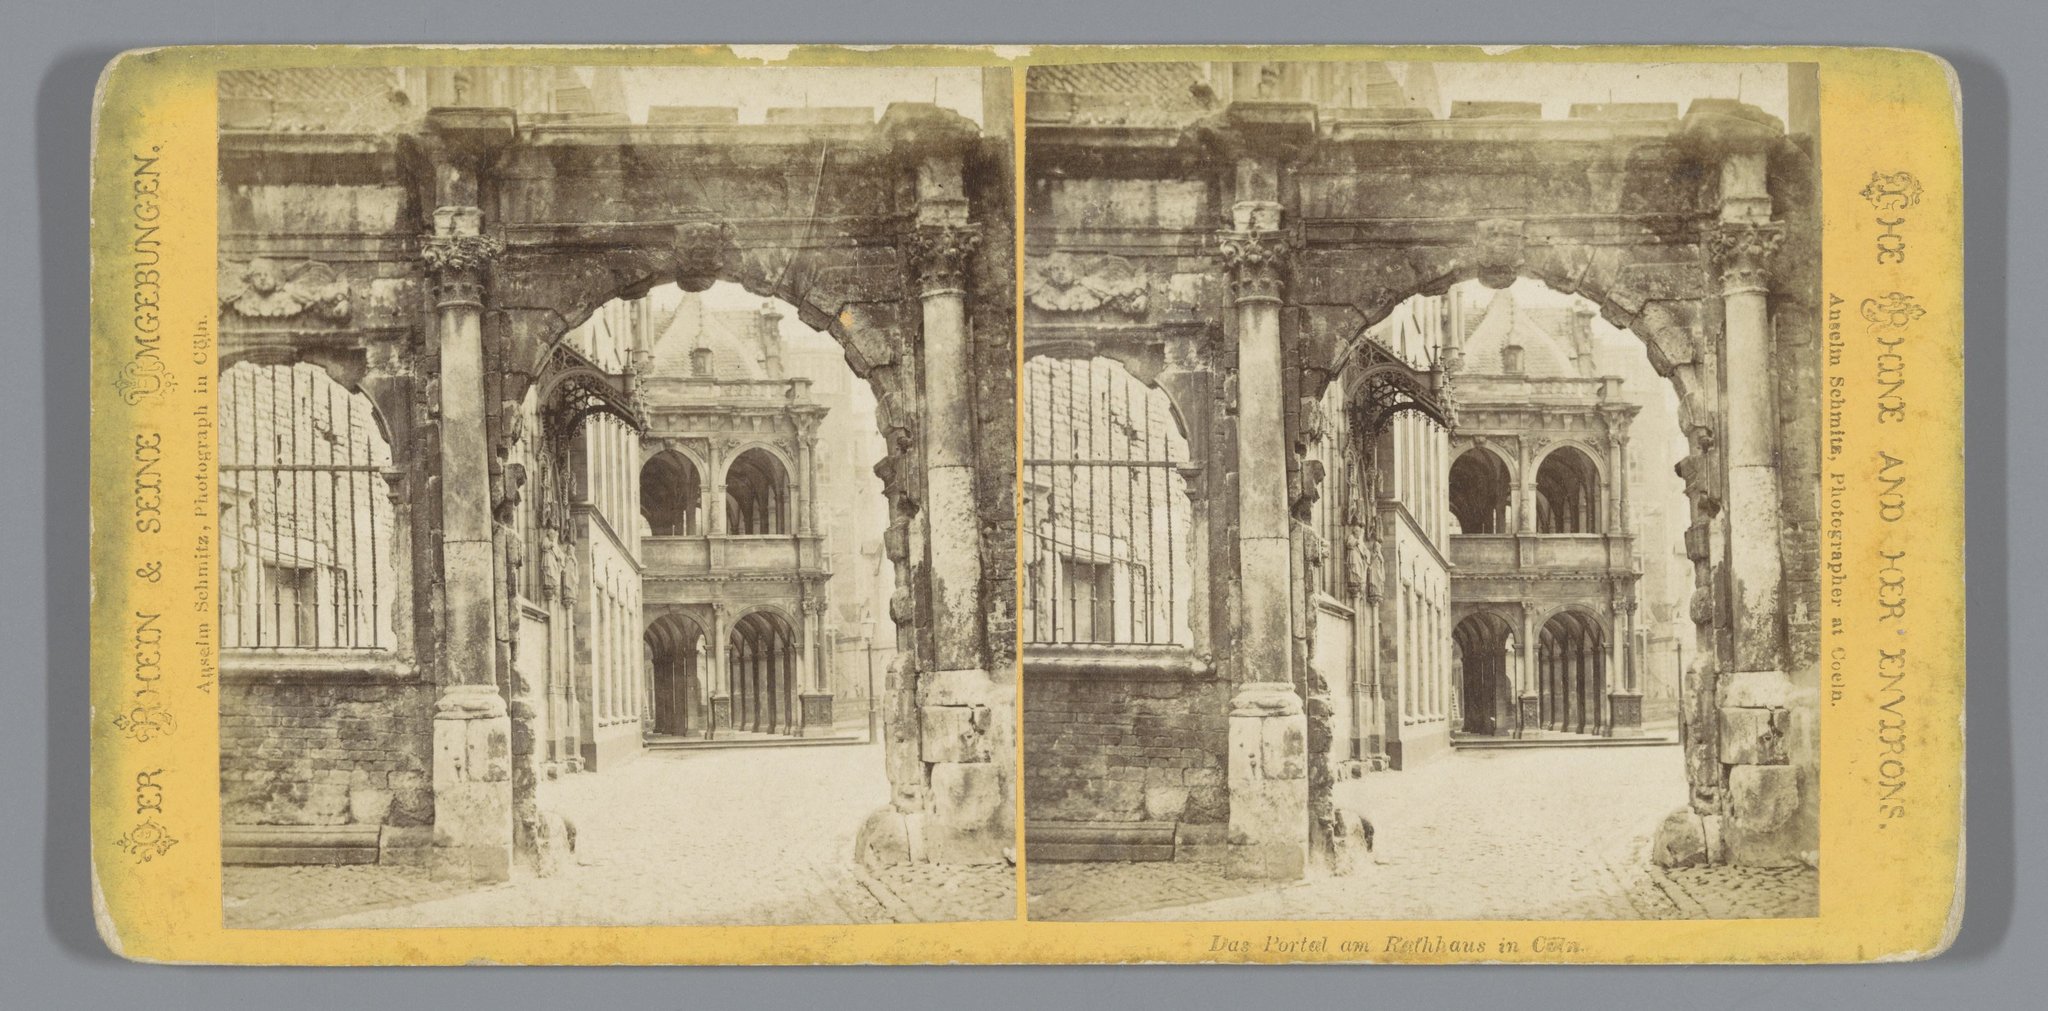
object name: stereograph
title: Das Portal am Rathhaus in Coln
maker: anselm schmitz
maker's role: publisher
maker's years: 1831-1903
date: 1860-1870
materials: cardboard, photographic support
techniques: albumen print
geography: cologne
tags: townhall